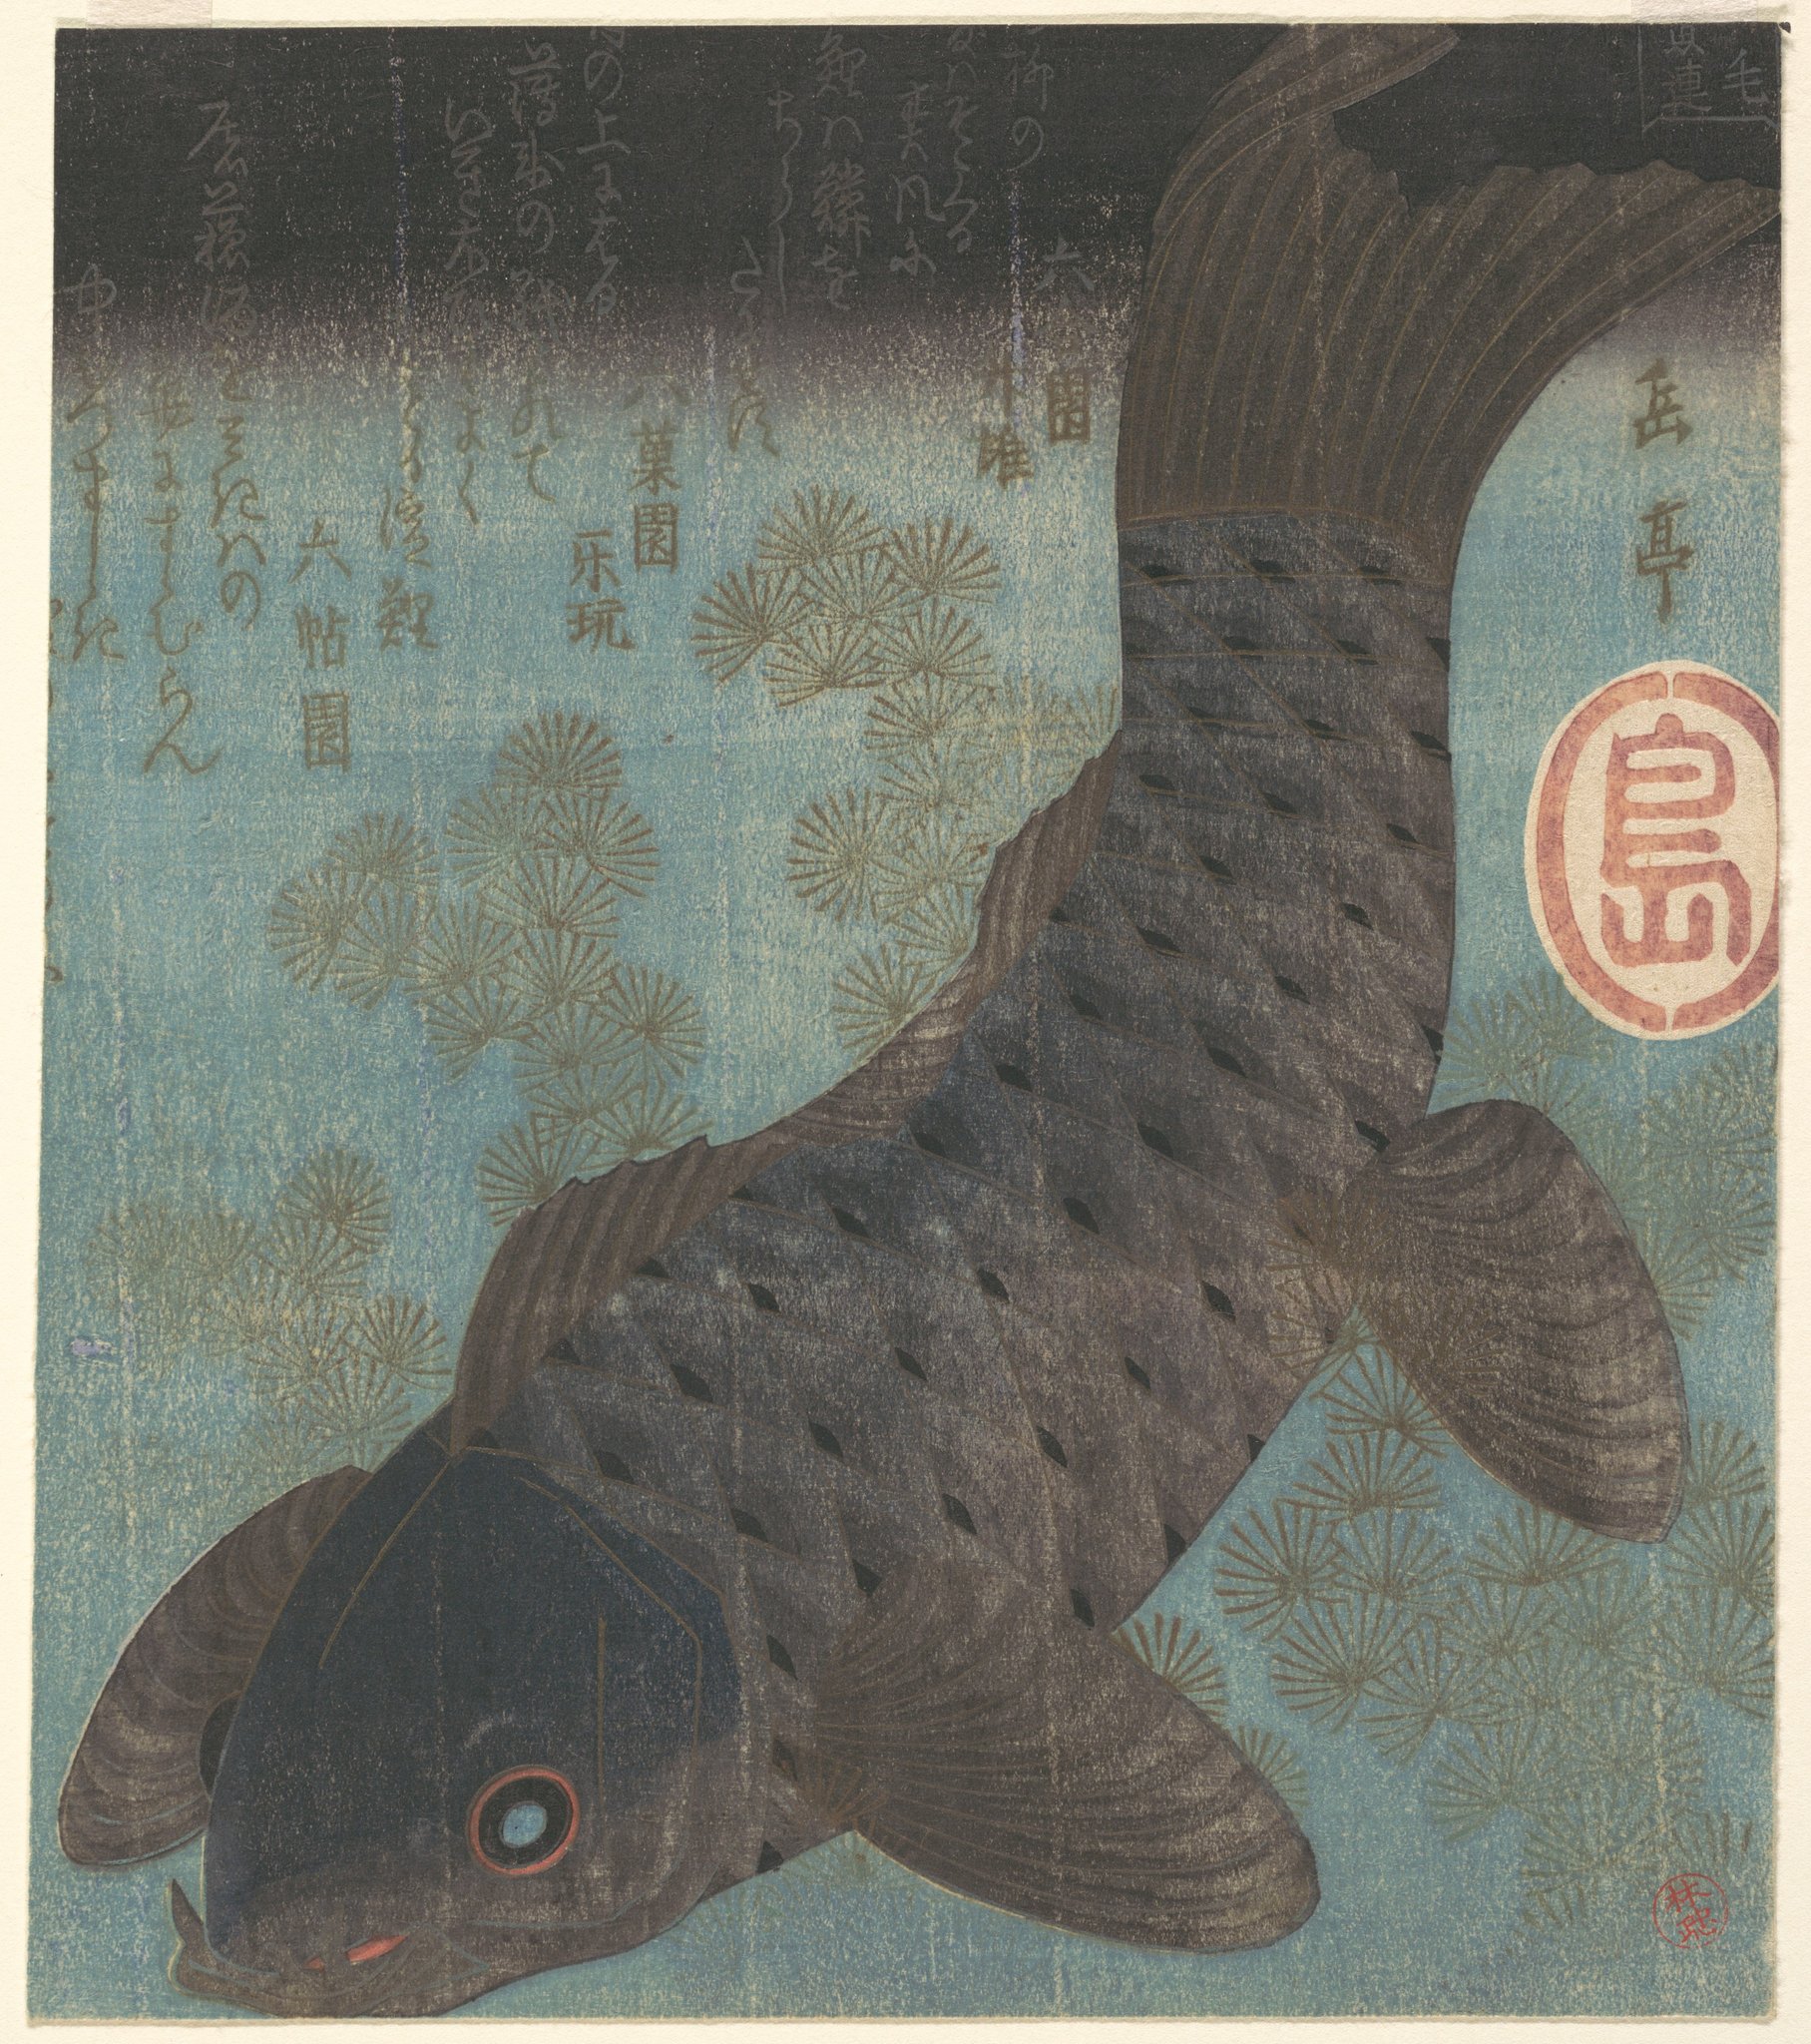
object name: woodblock print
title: Carp and Pine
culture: japanese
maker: yashima gakutei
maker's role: artist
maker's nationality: japanese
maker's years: 1786-1868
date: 1786-1868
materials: ink, paper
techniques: surimono, woodblock print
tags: fish